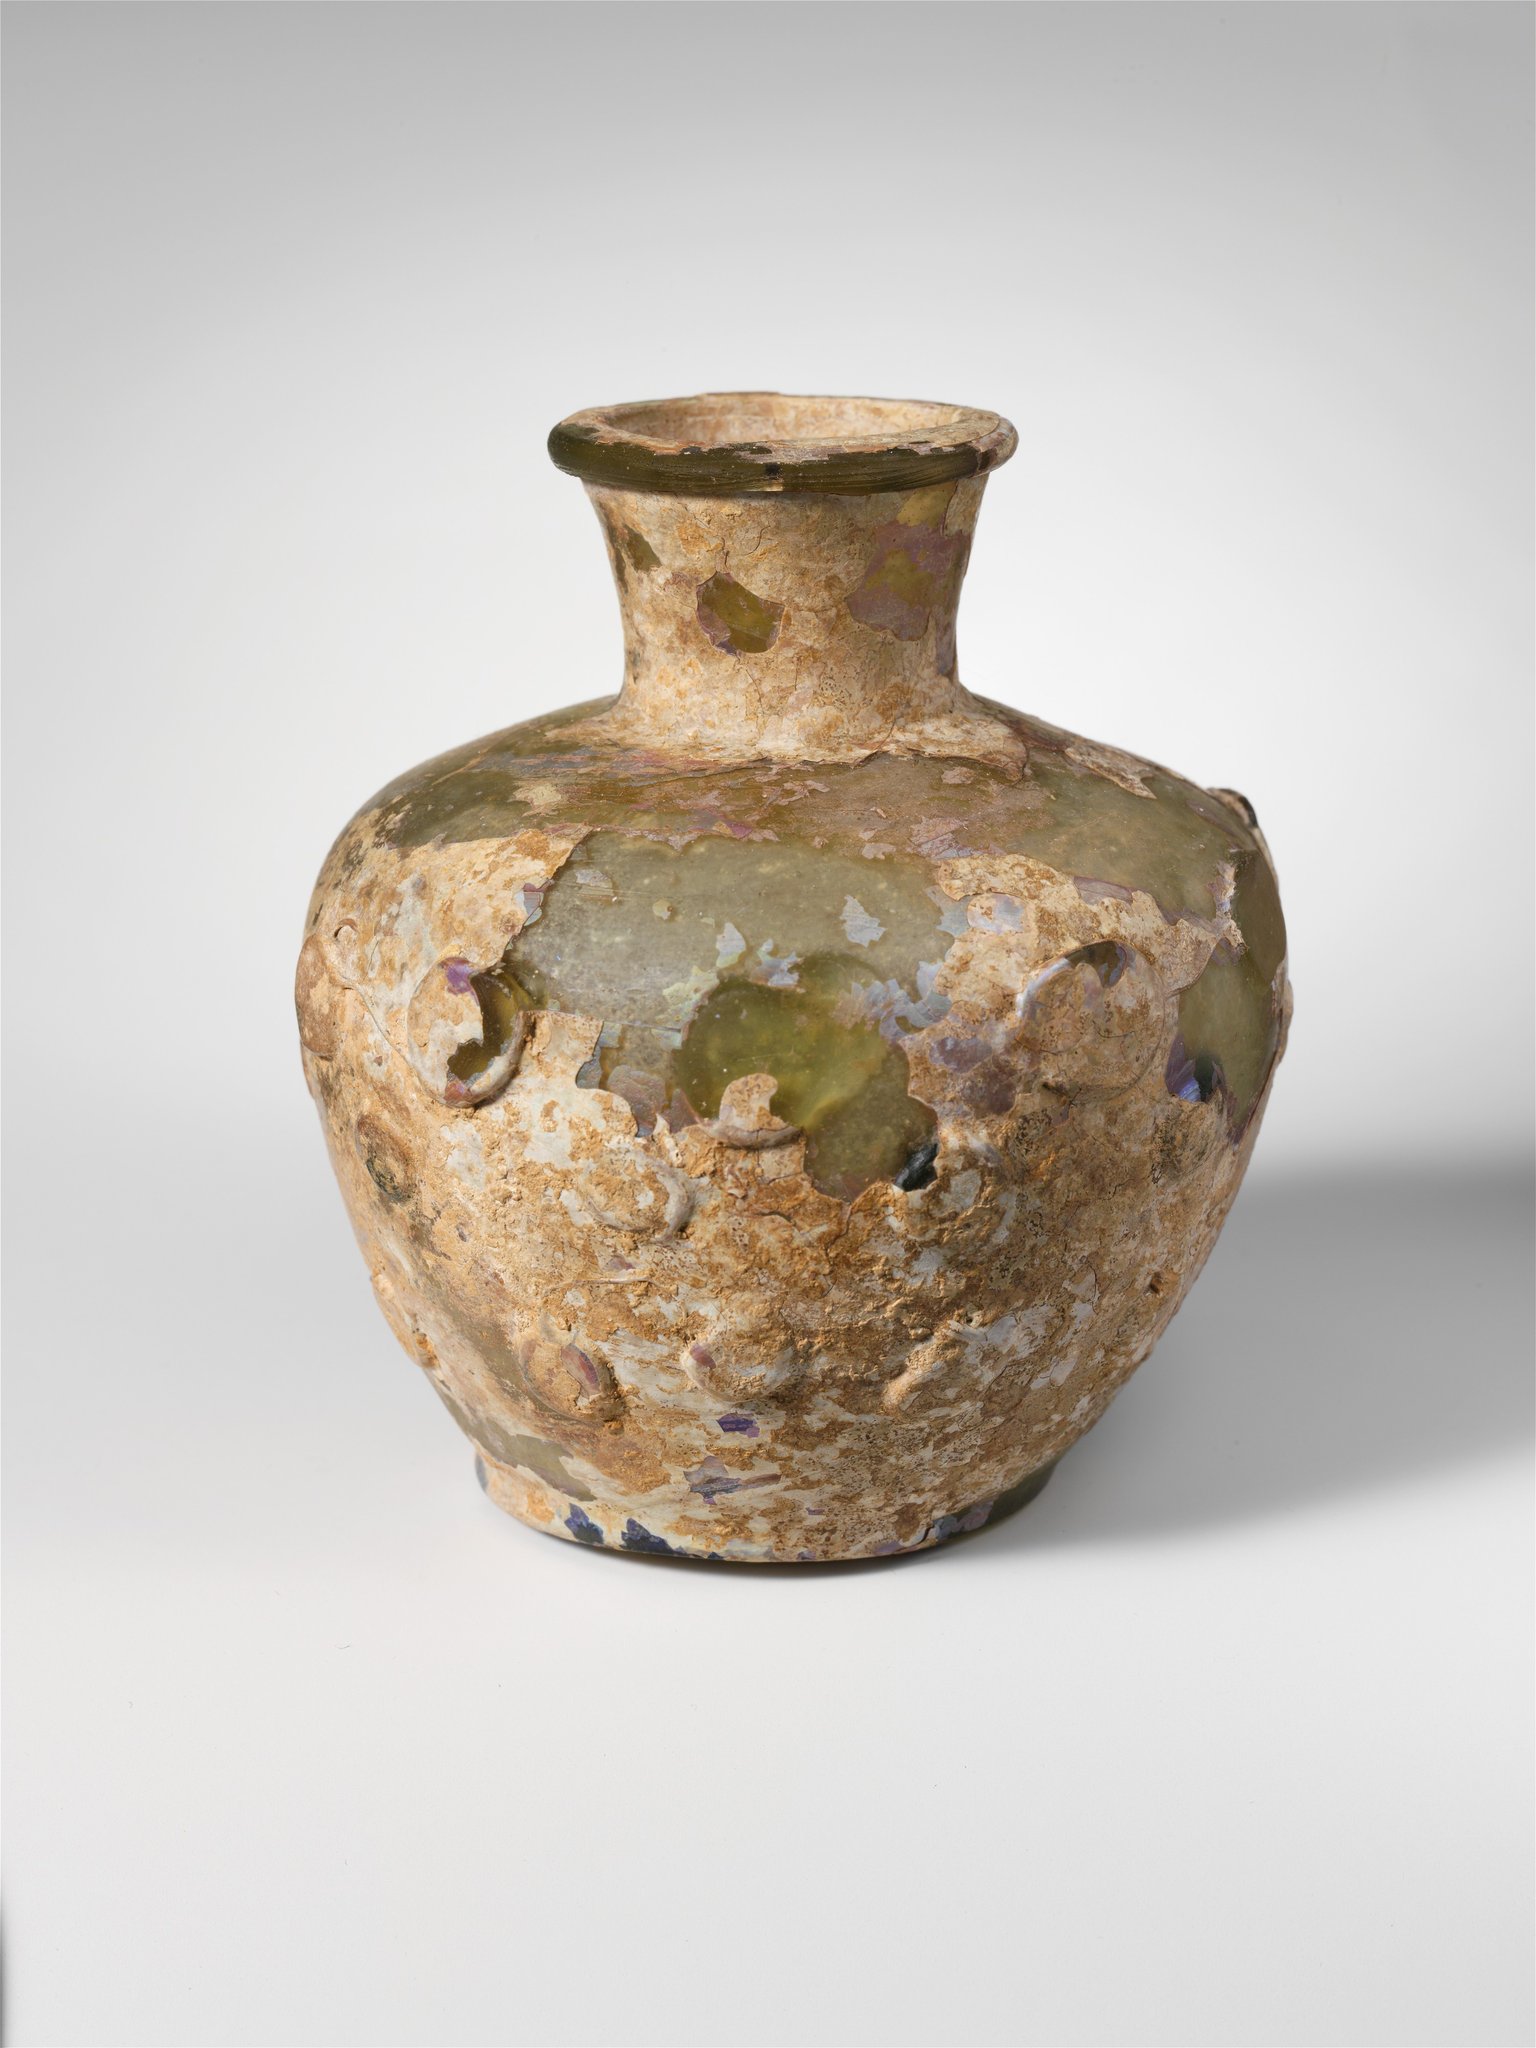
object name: jar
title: Glass jar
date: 7000 BCE-330 CE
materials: glass